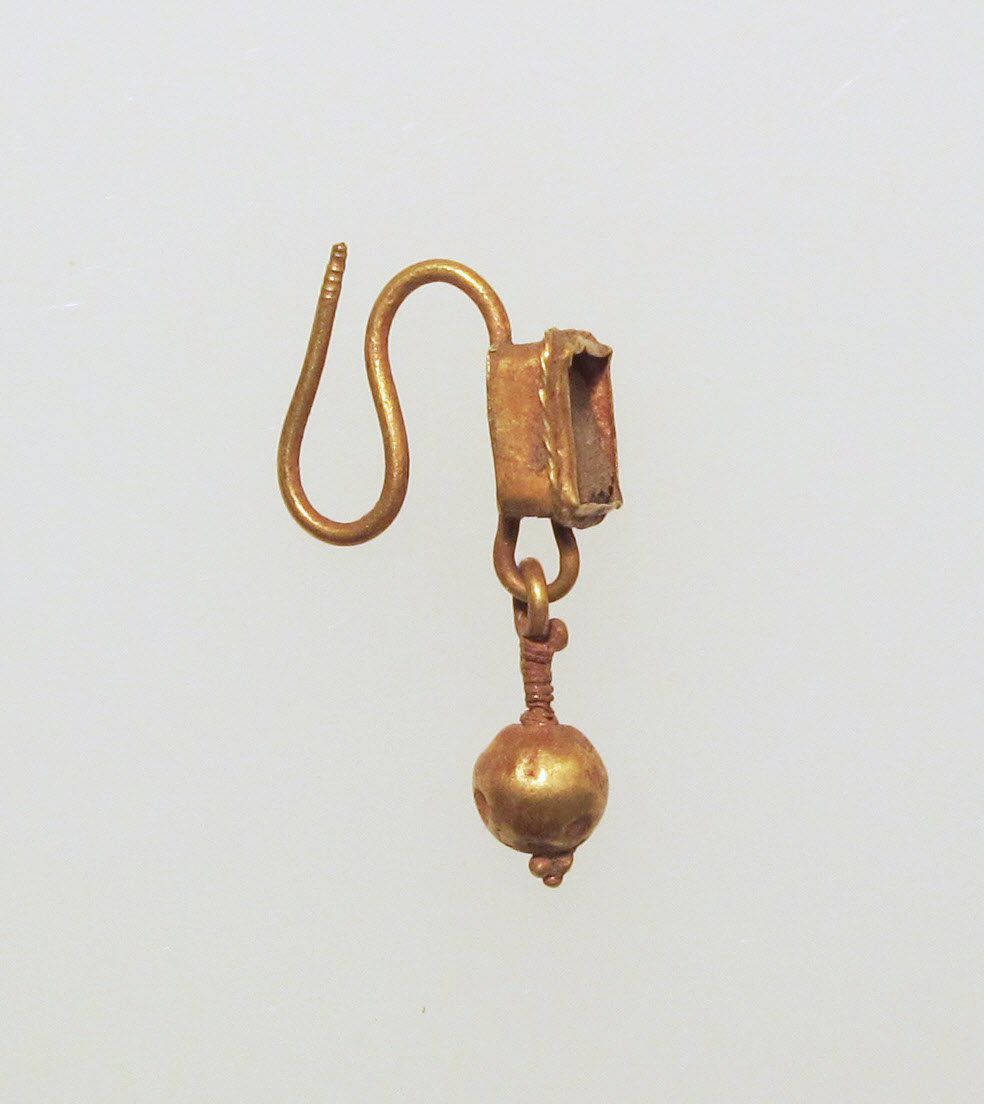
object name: earring hook type with pendant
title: Earring-hook type with pendant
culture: roman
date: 7000 BCE-330 CE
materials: gold